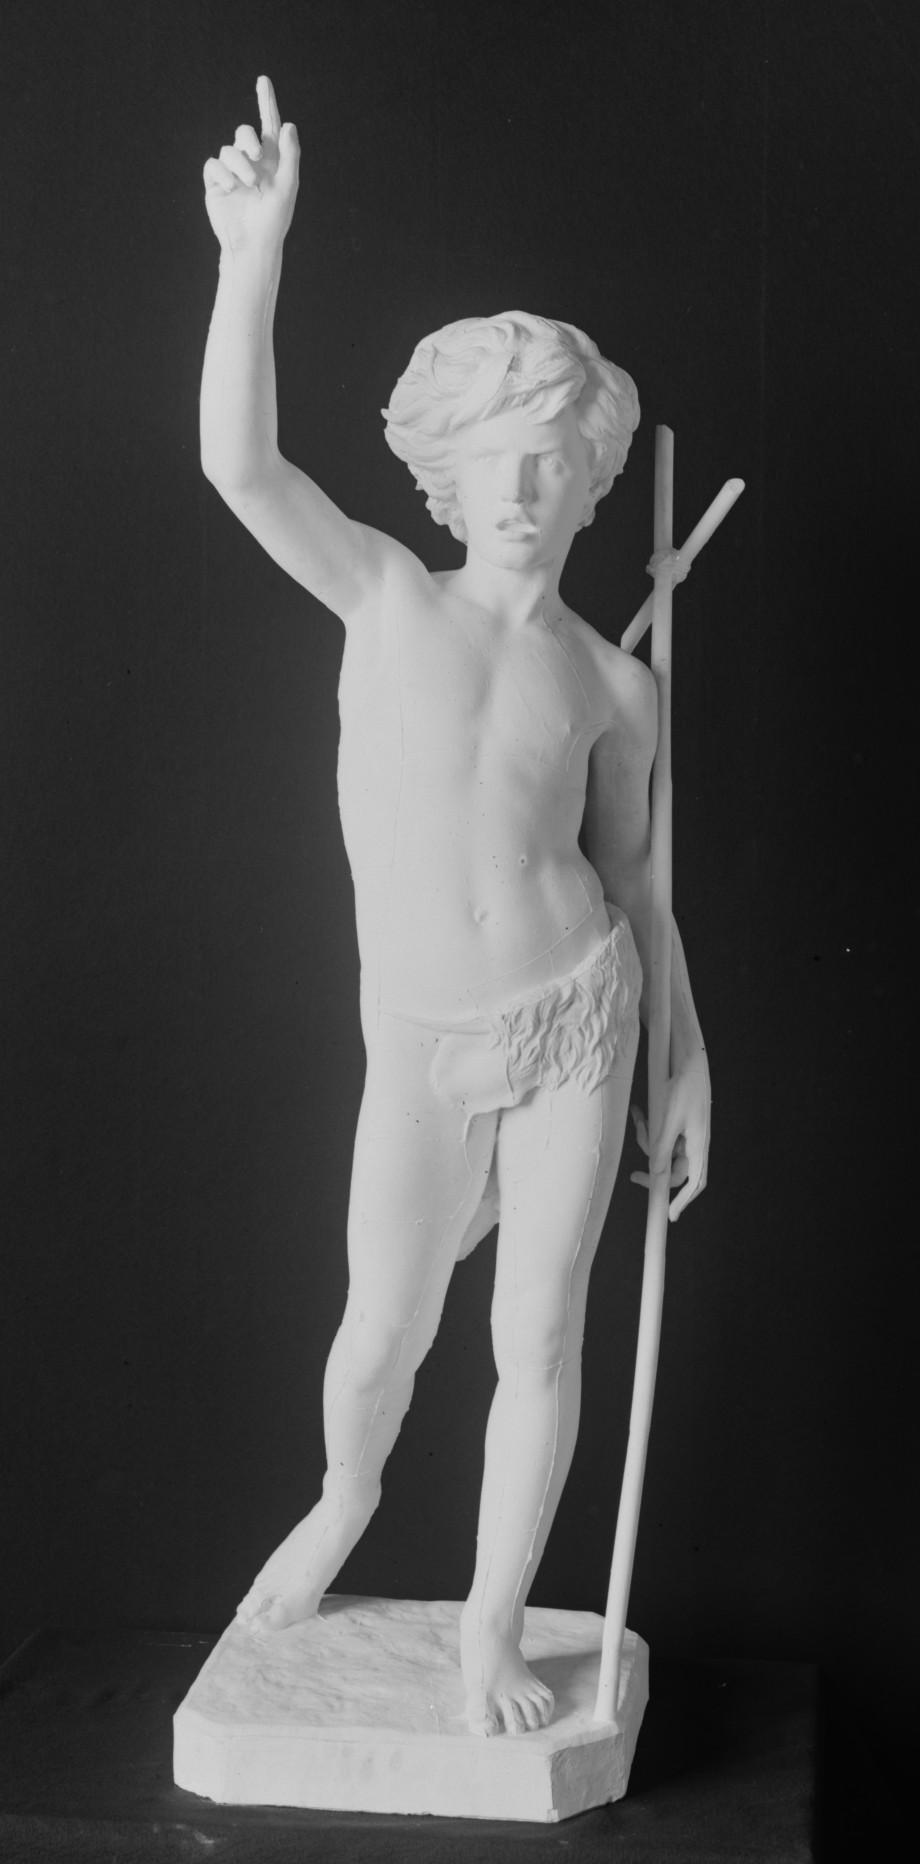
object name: statuette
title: Saint John the Baptist as a child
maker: paul dubois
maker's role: artist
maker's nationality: french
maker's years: 1829-1905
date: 1863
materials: plaster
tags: saint john the baptist